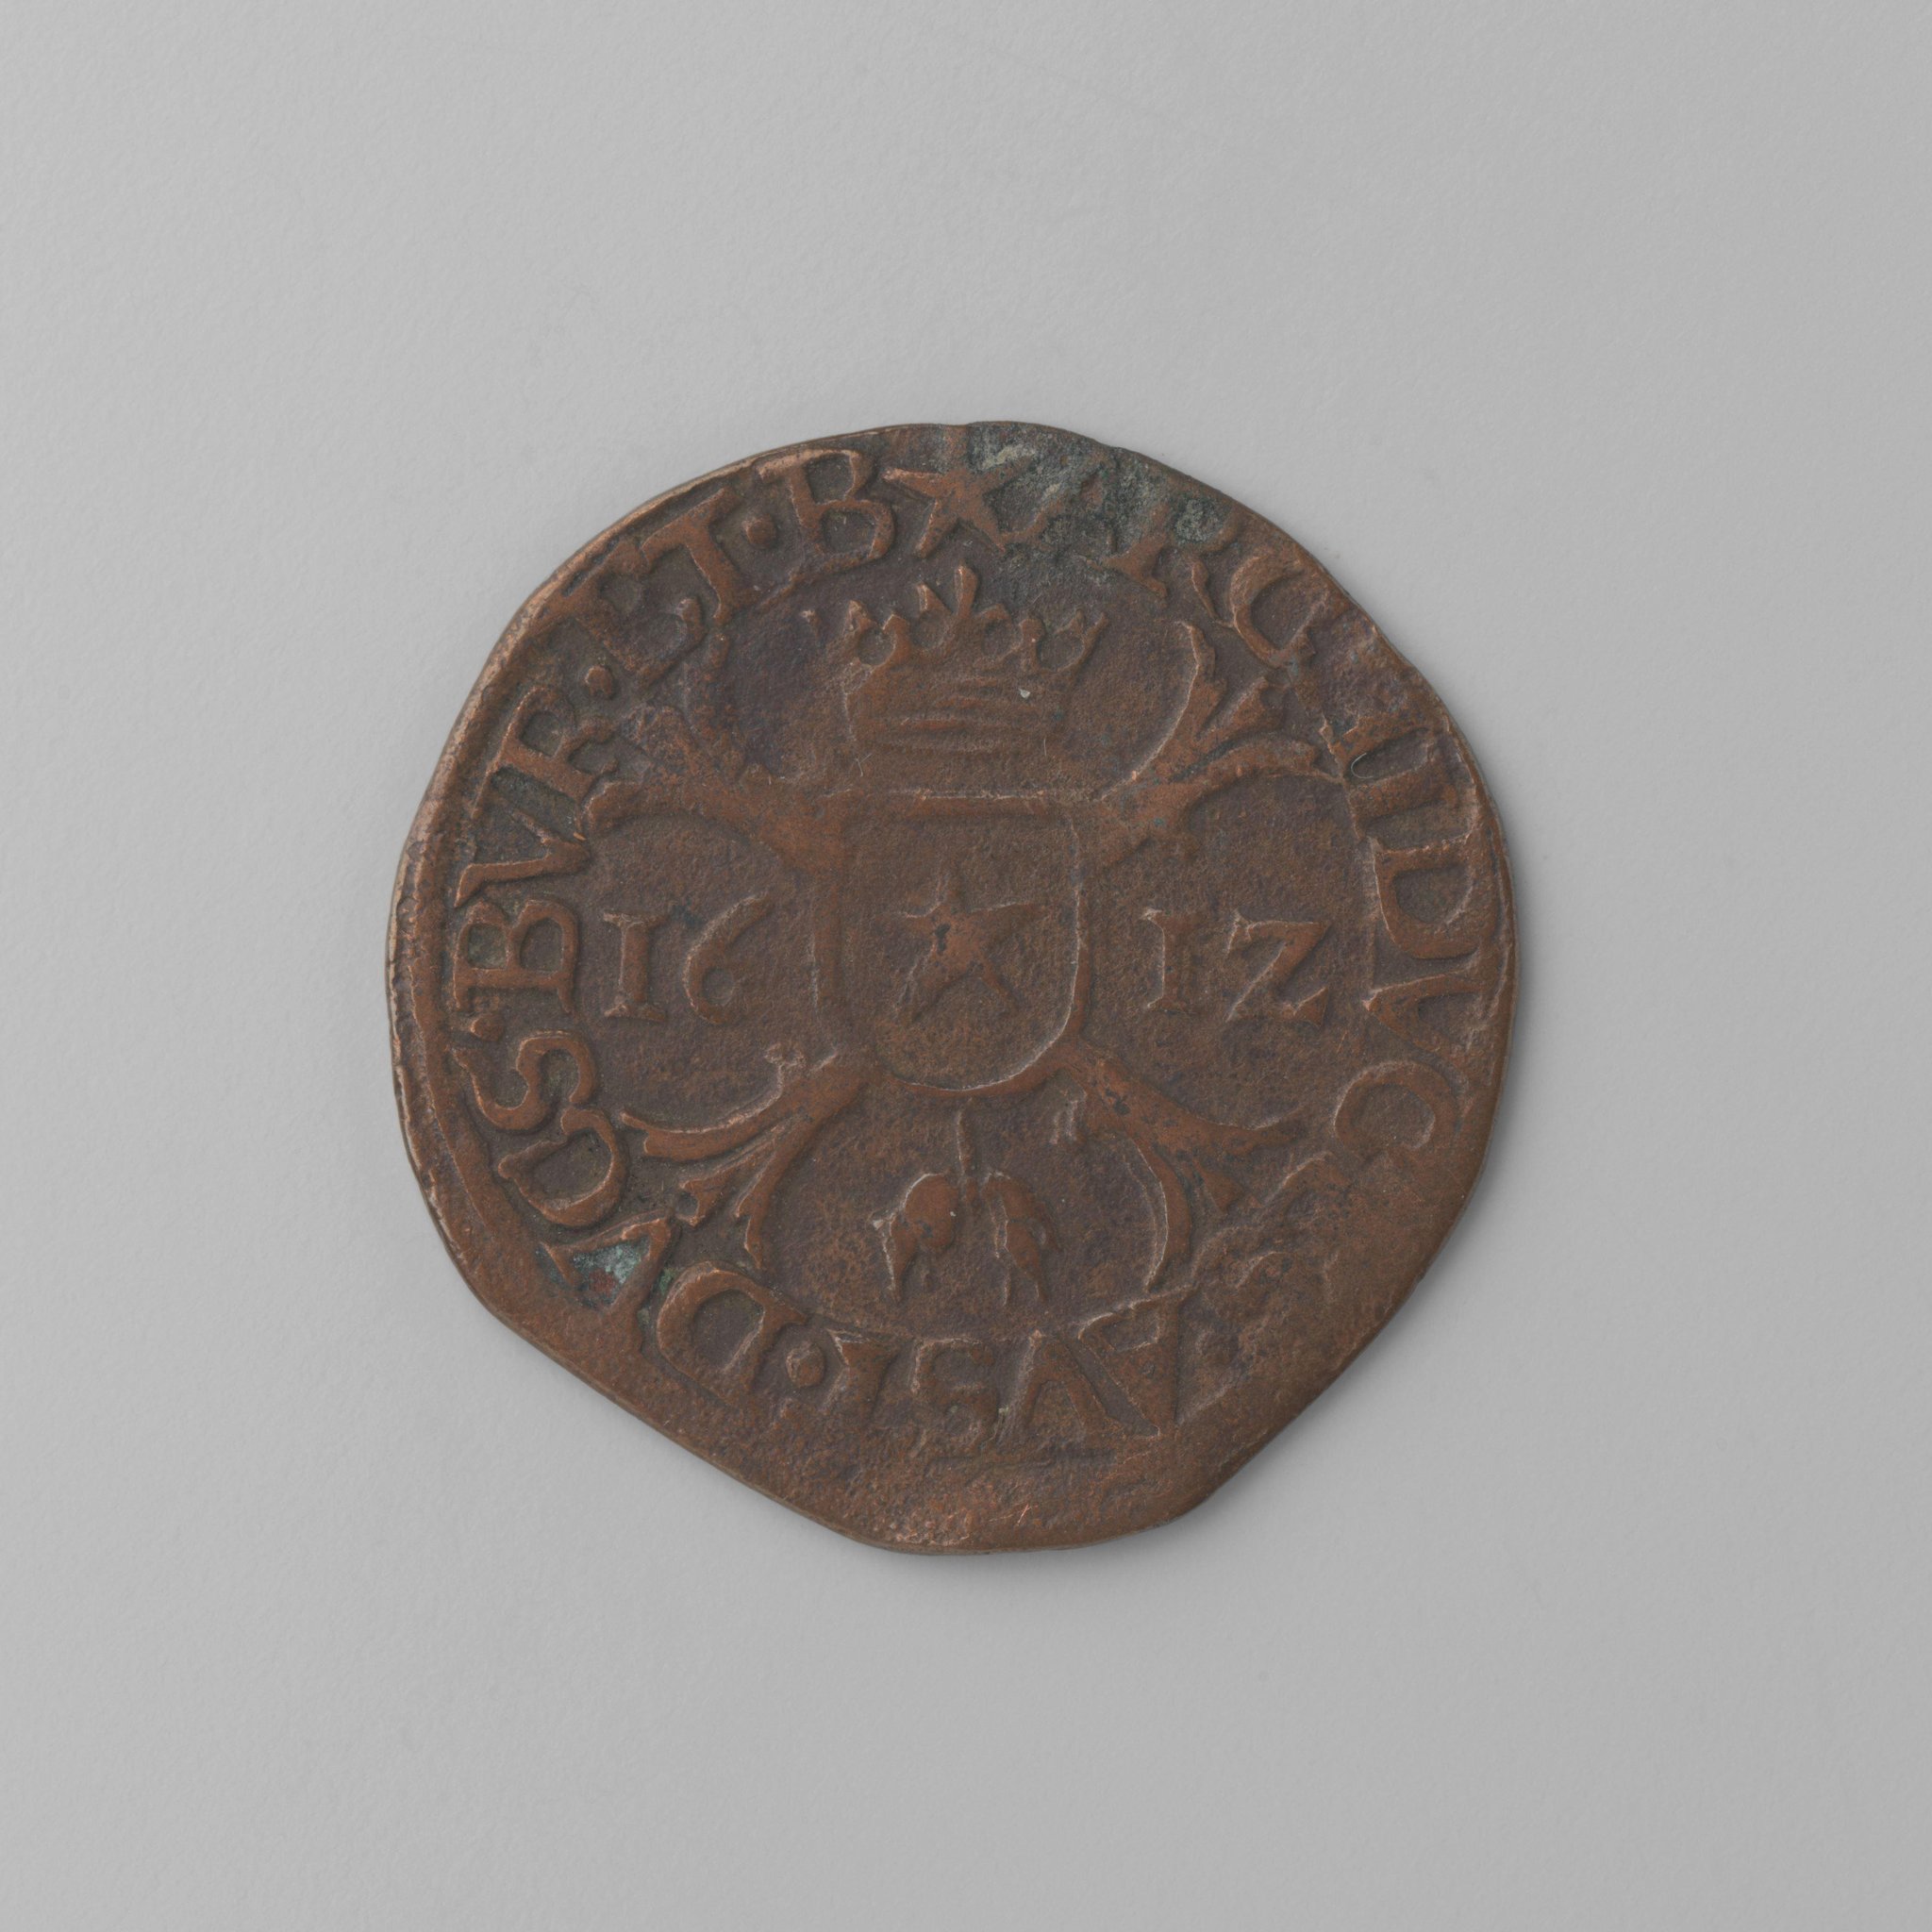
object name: coin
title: Oord van aartshertogen Albert en Isabella, hertogen van Brabant, 1612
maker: hertog van brabant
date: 1612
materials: copper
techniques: striking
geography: maastricht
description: Koperen munt. Voorzijde: tussen sterren [=muntteken van Maastricht] gekroond wapenschild. Keerzijde: tussen jaartal op stokkenkruis gekroond wapenschild van Maastricht, waaronder het Gulden Vlies.